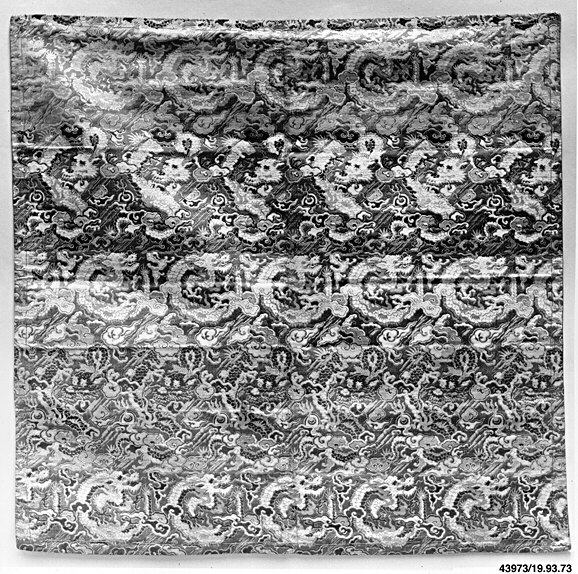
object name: altar cloth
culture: japanese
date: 1615-1868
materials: metal thread, silk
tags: dragons